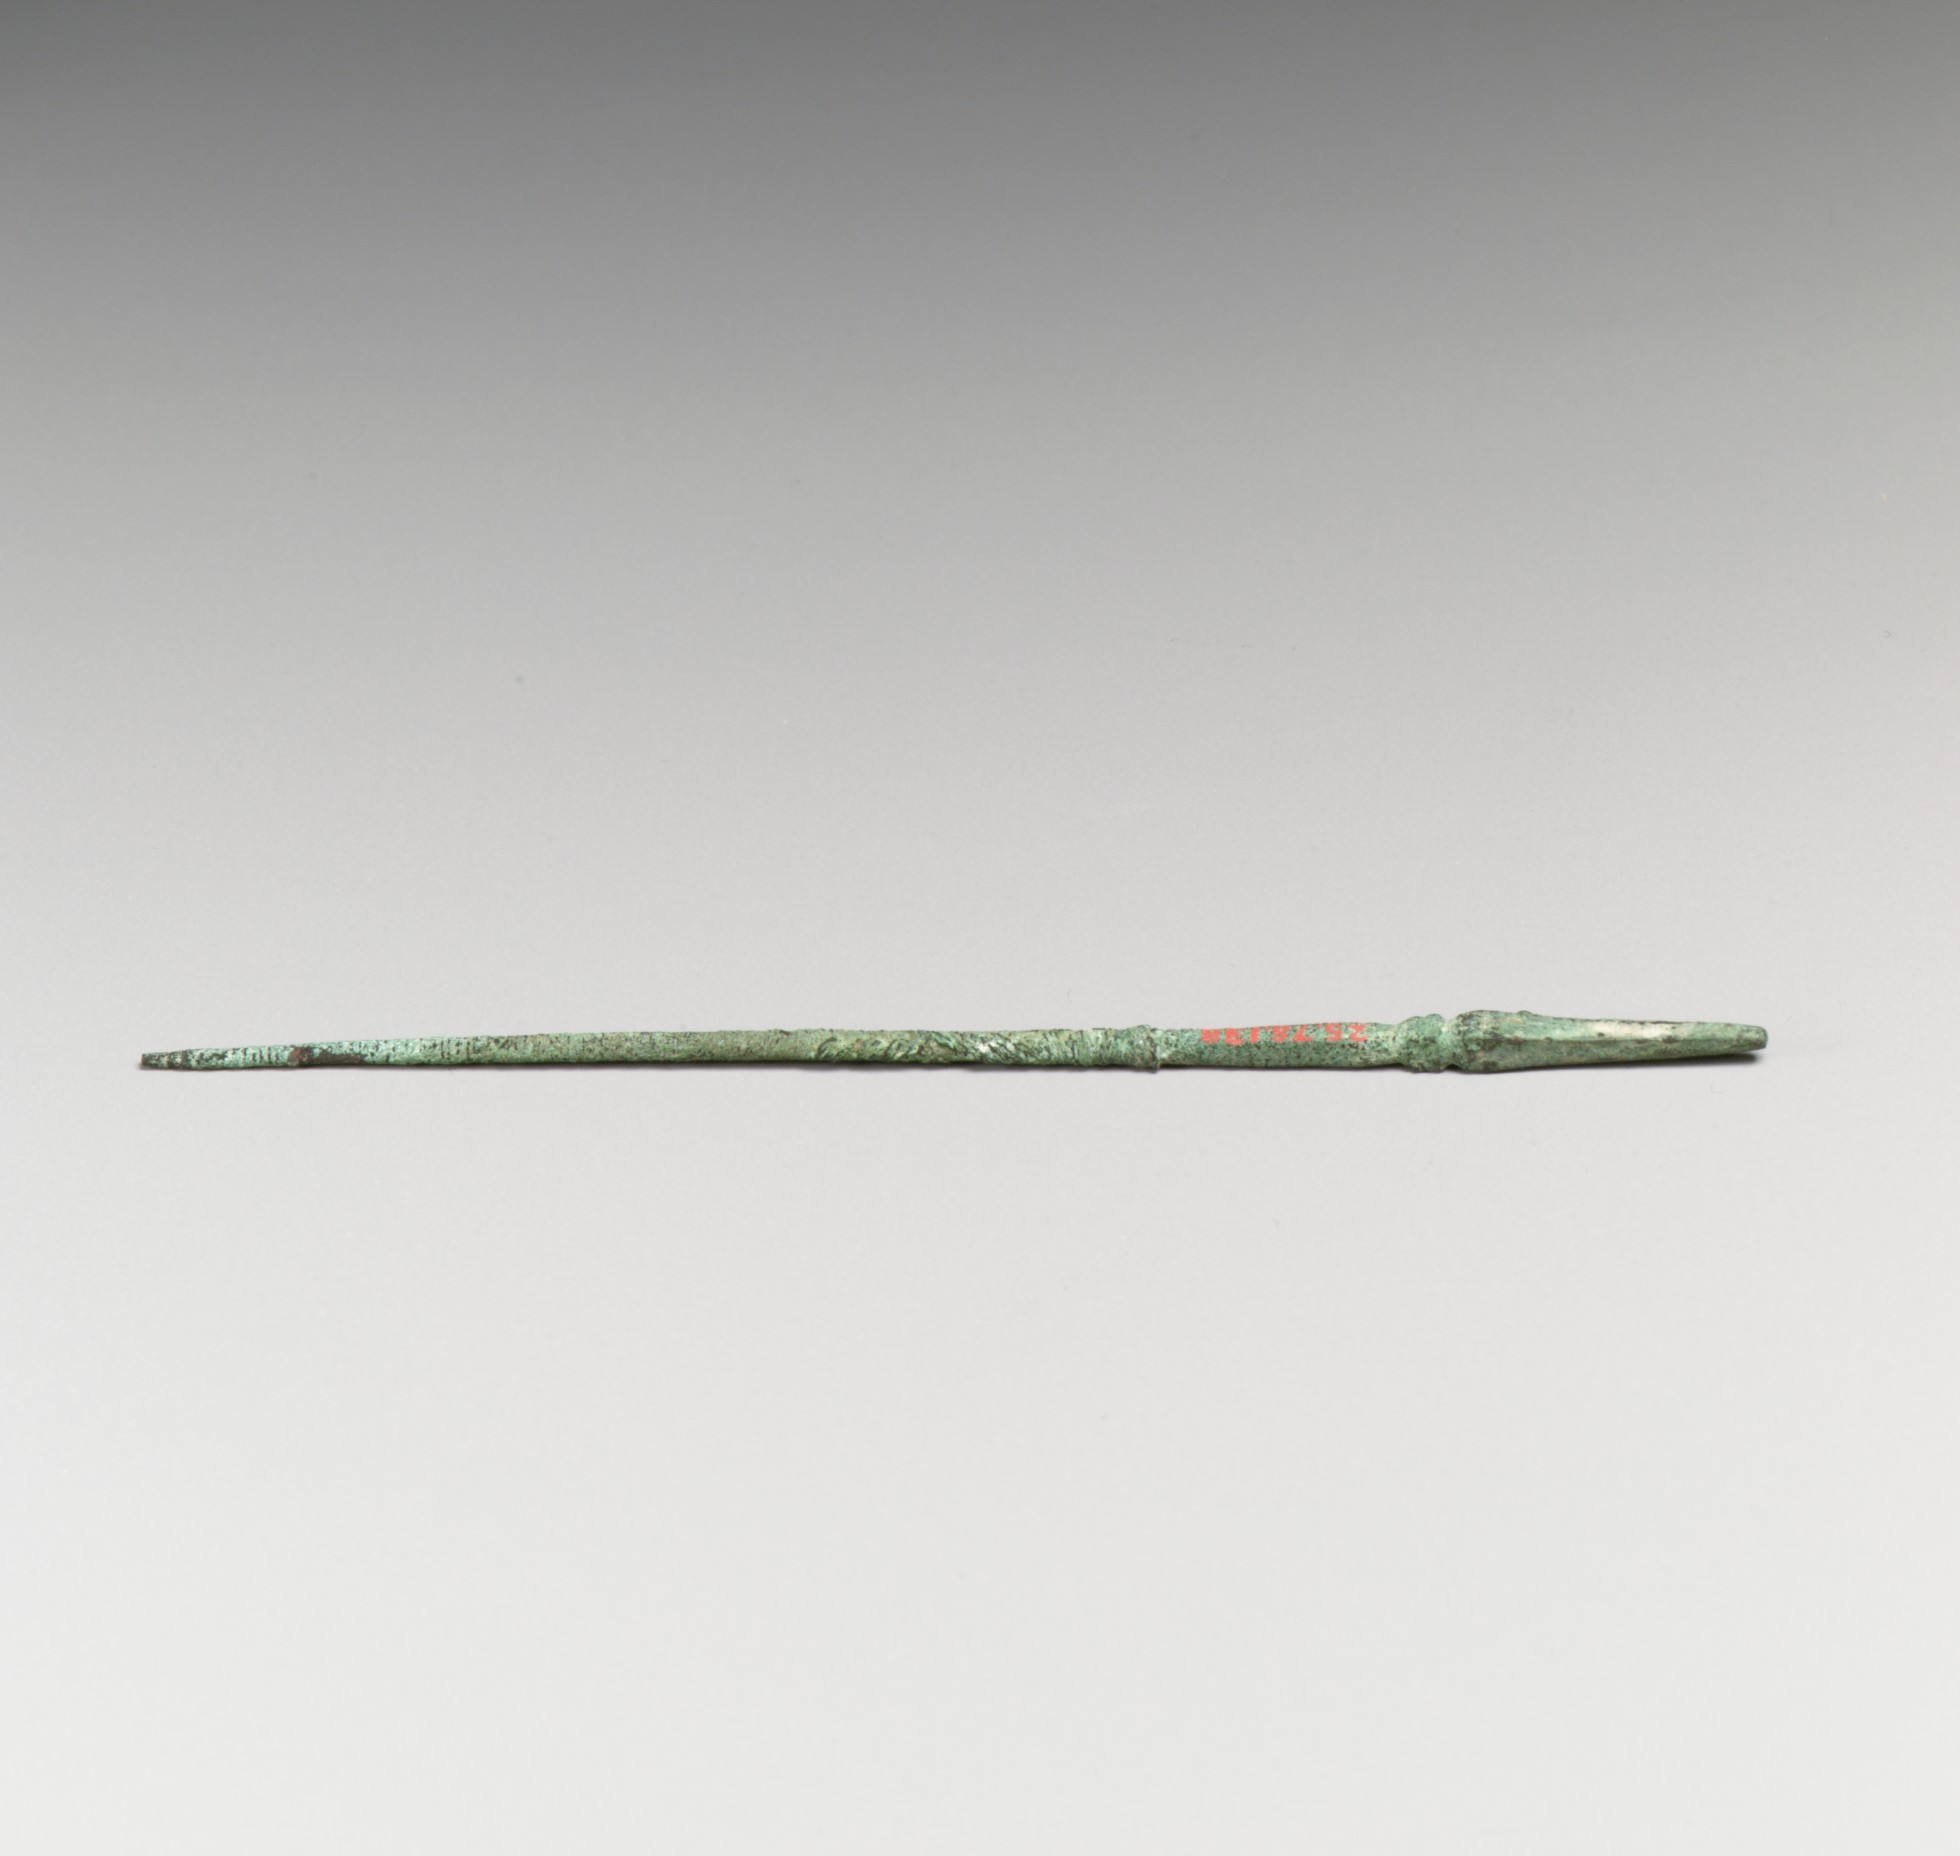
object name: stylus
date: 7000 BCE-330 CE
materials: bronze